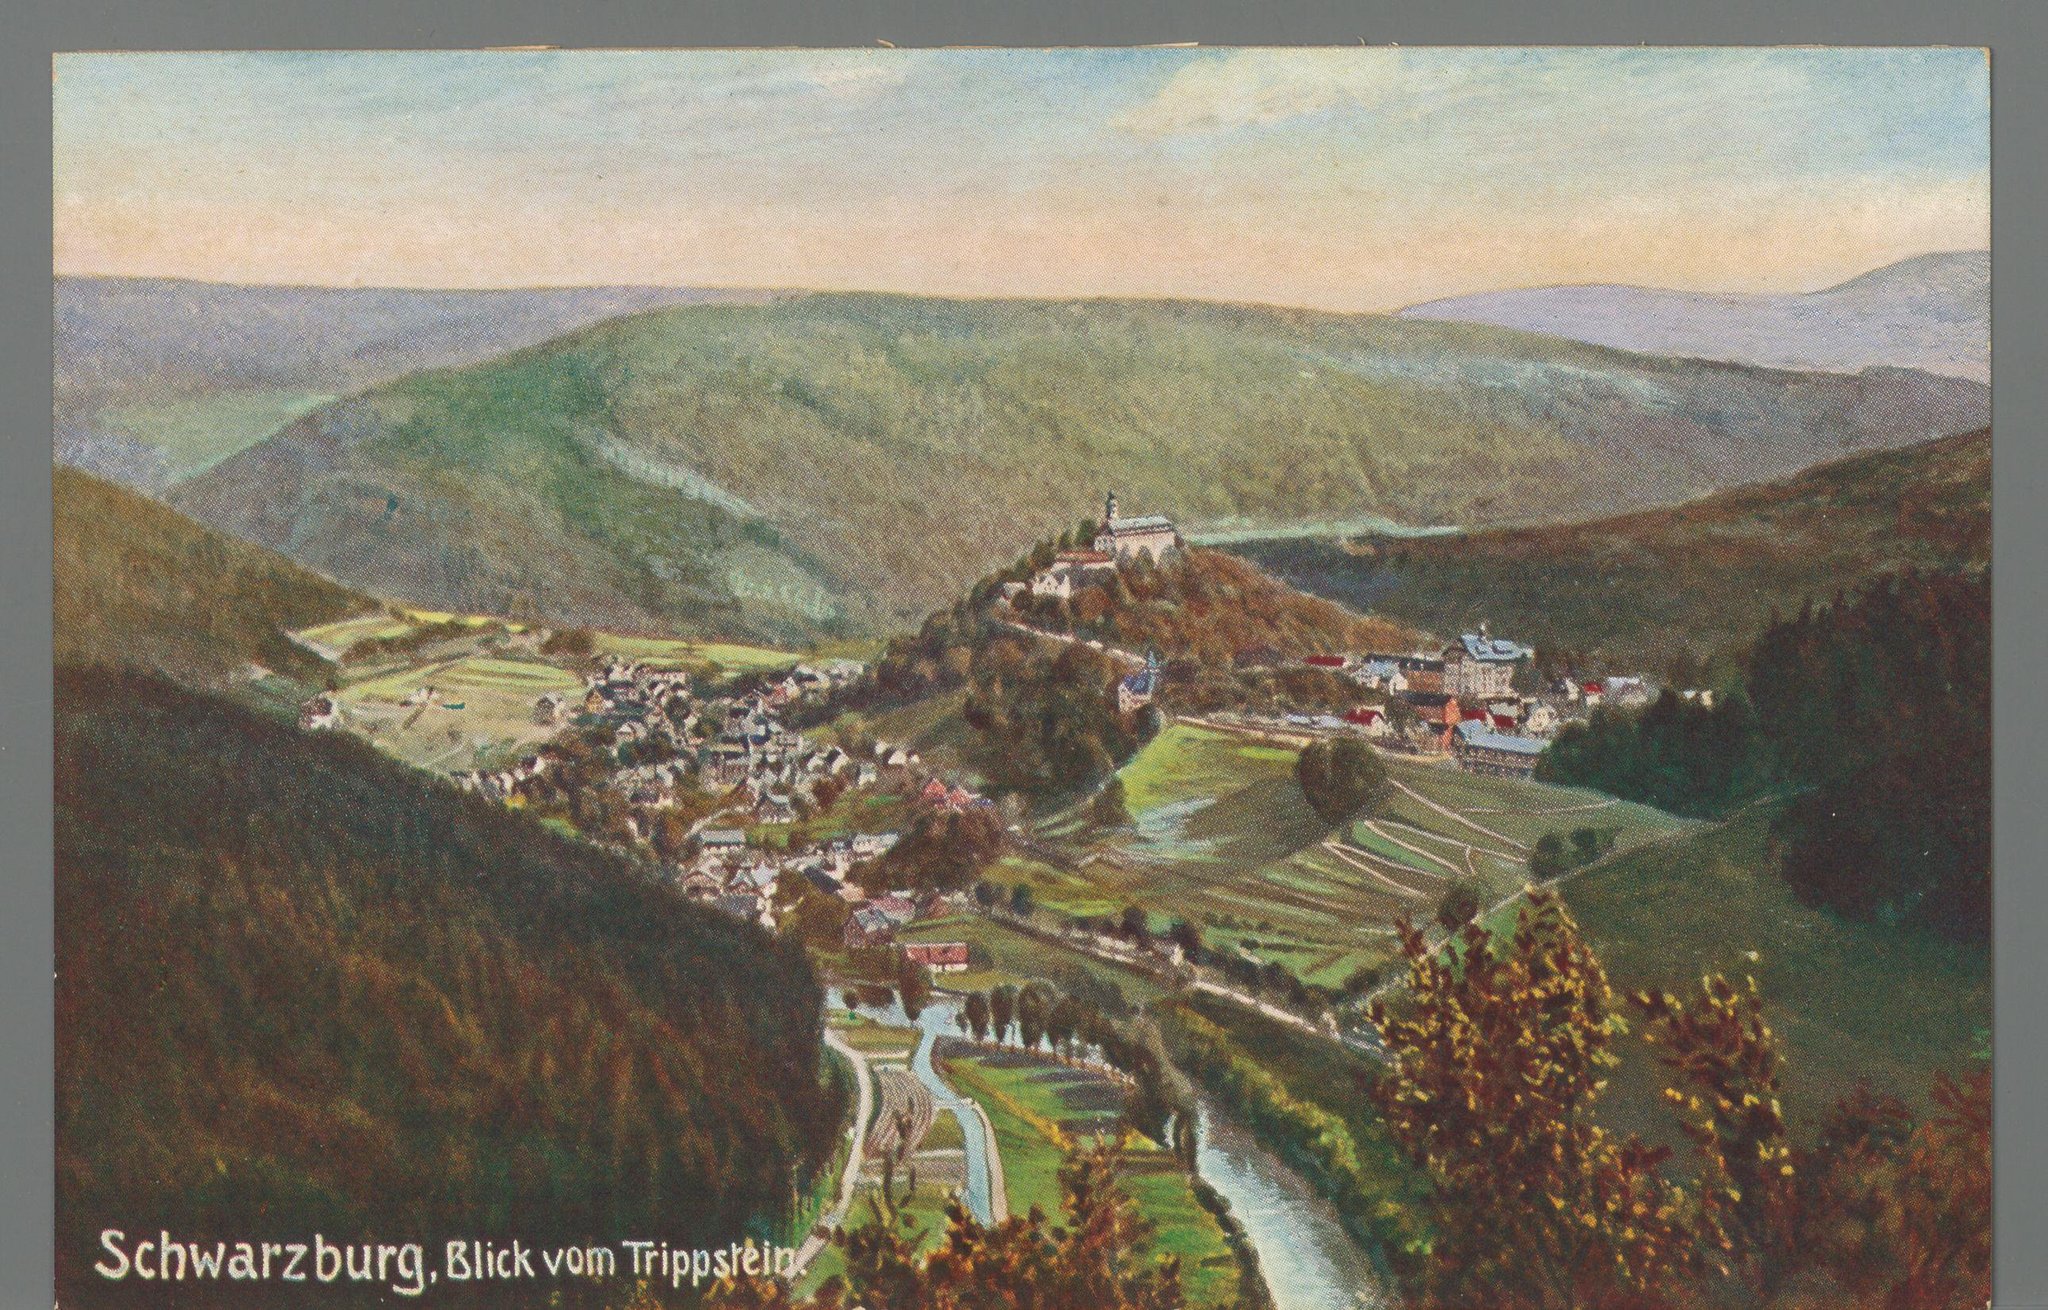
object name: photomechanical print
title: Schwarzburg, Blick vom Trippstein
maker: karl thomass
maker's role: lithograaf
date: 1905-1930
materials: cardboard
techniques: color autotype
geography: gehren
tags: city-view, and landscape with man-made constructions, mountains